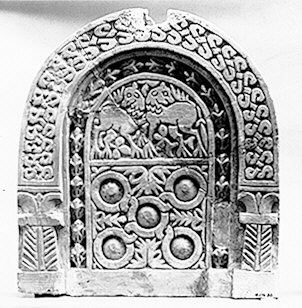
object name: stele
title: Funerary Stele with Two Lions and Circle Pattern within a Niche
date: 601-800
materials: limestone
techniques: carving, relief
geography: egypt